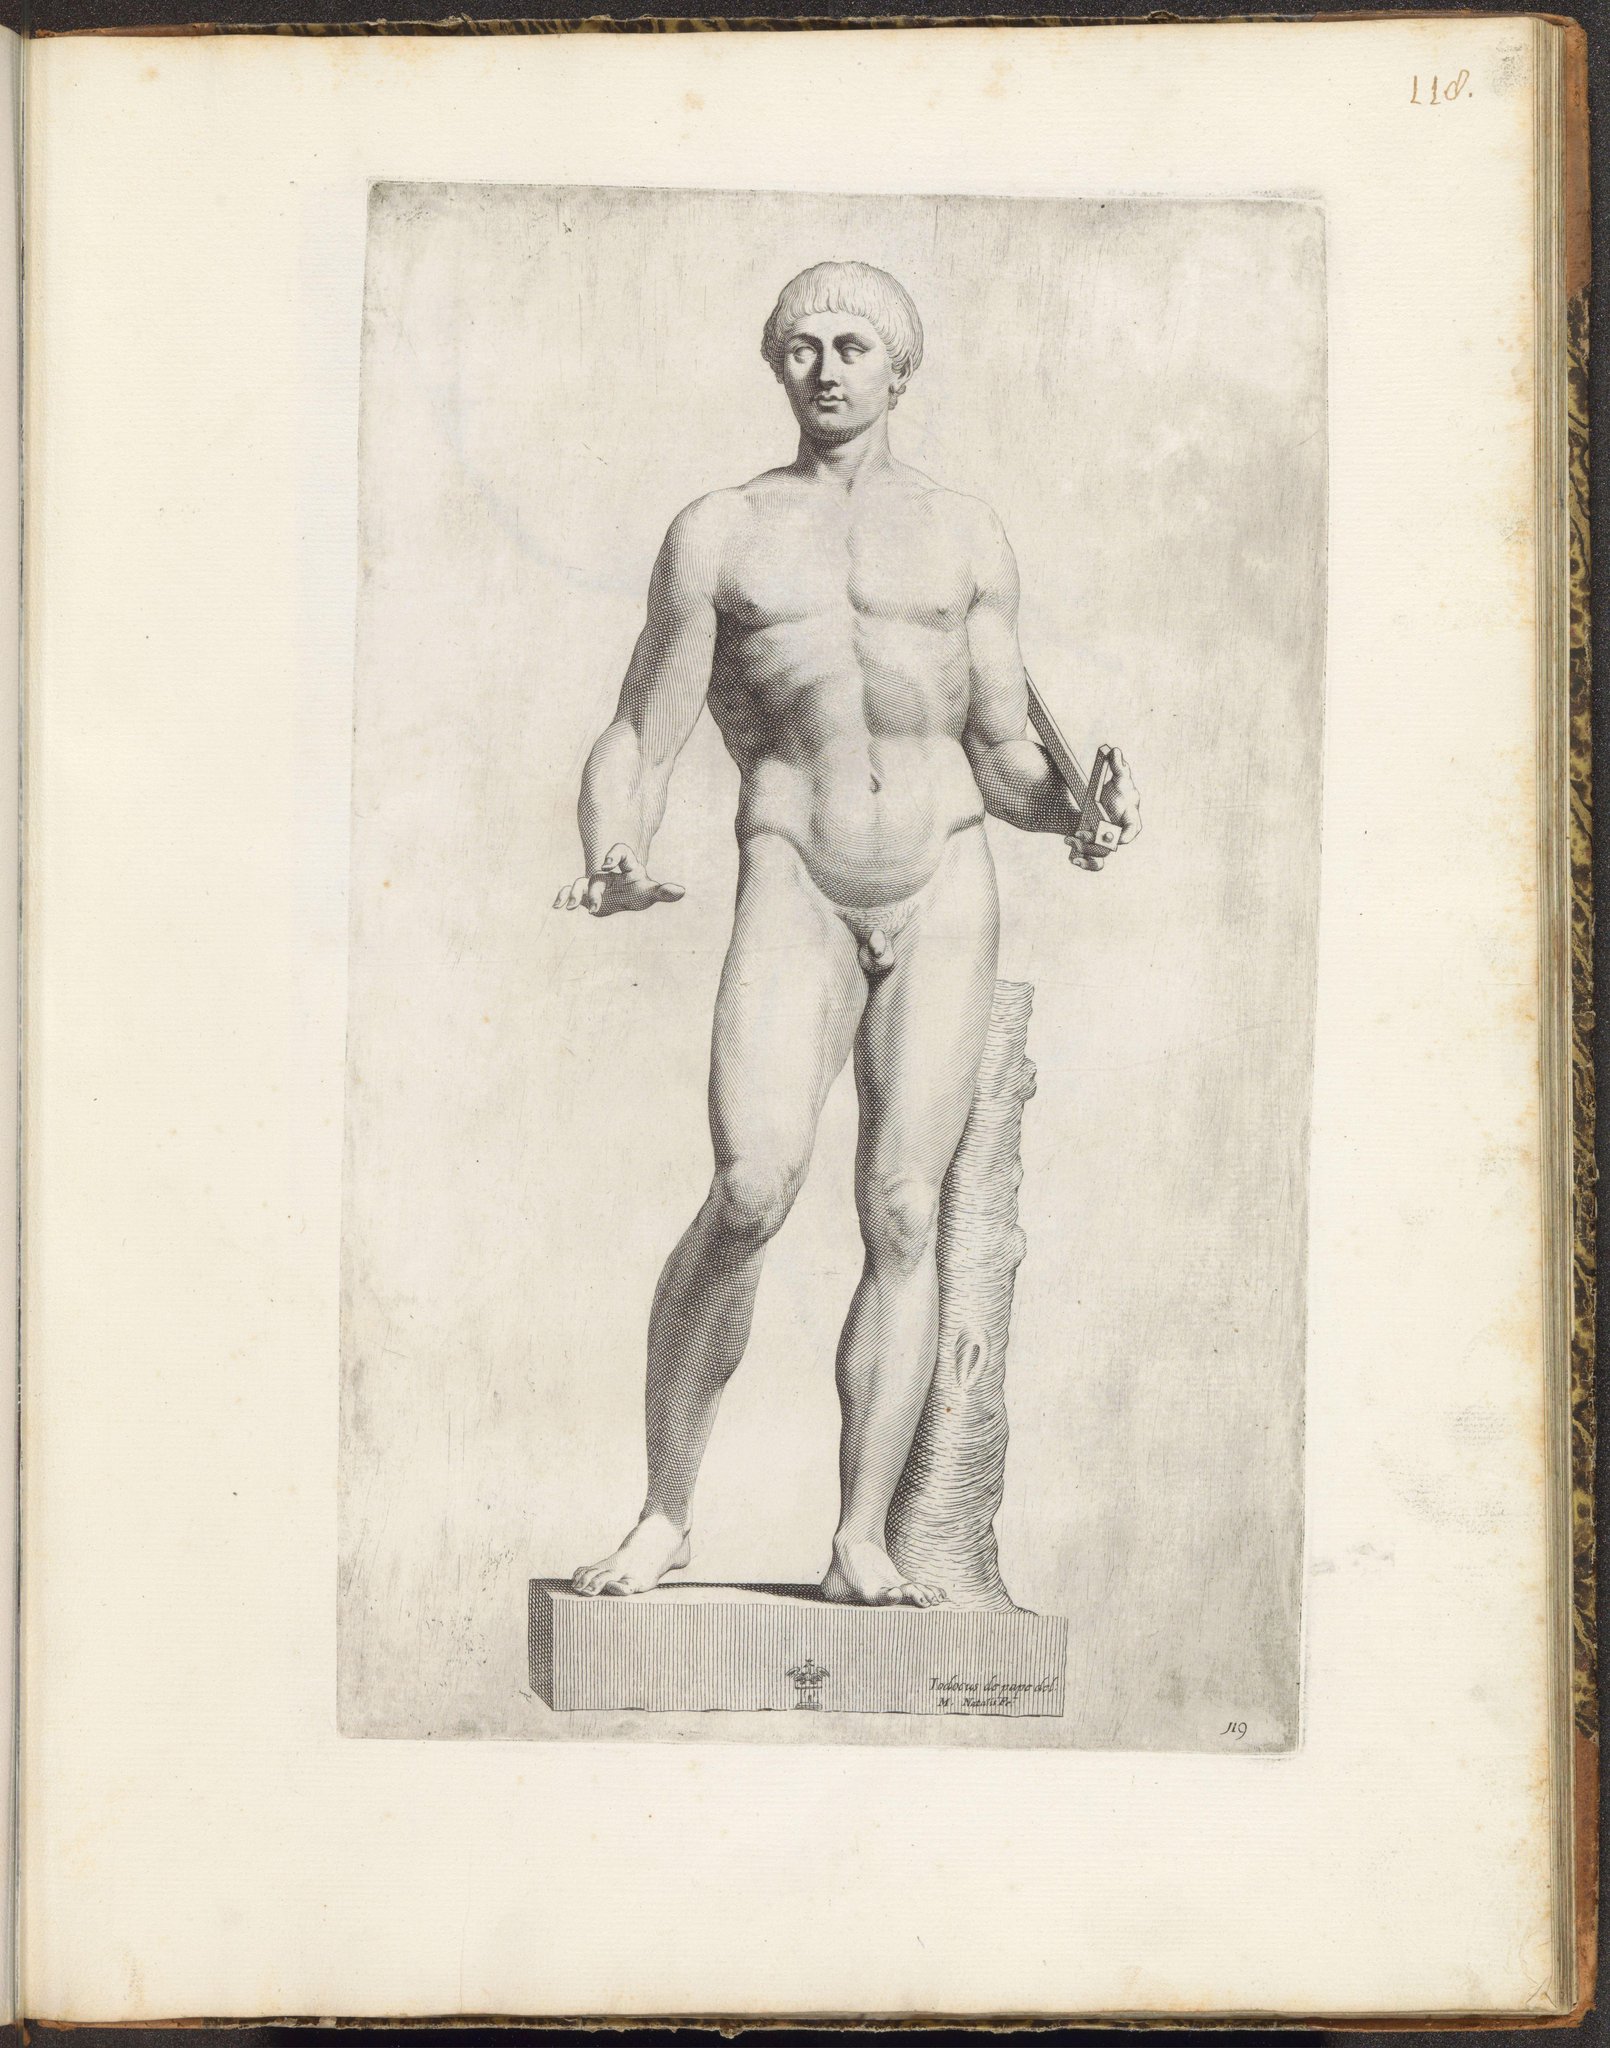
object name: print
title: Standbeeld van een staande man met zwaard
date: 1636-1647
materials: paper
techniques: engraving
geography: rome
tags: piece of sculpture, reproduction of a piece of sculpture, fight of gladiators (+ sportsman, player, etc.)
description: Standbeeld van een naakte man met een zwaard in zijn linkerhand, staande naast een boomstam. Midden onder op de basis het wapenschild van Vincenzo Giustiniani. Prent maakt deel uit van een album met een serie prenten naar de sculpturen in de verzameling in de Galleria Giustiniani te Rome.